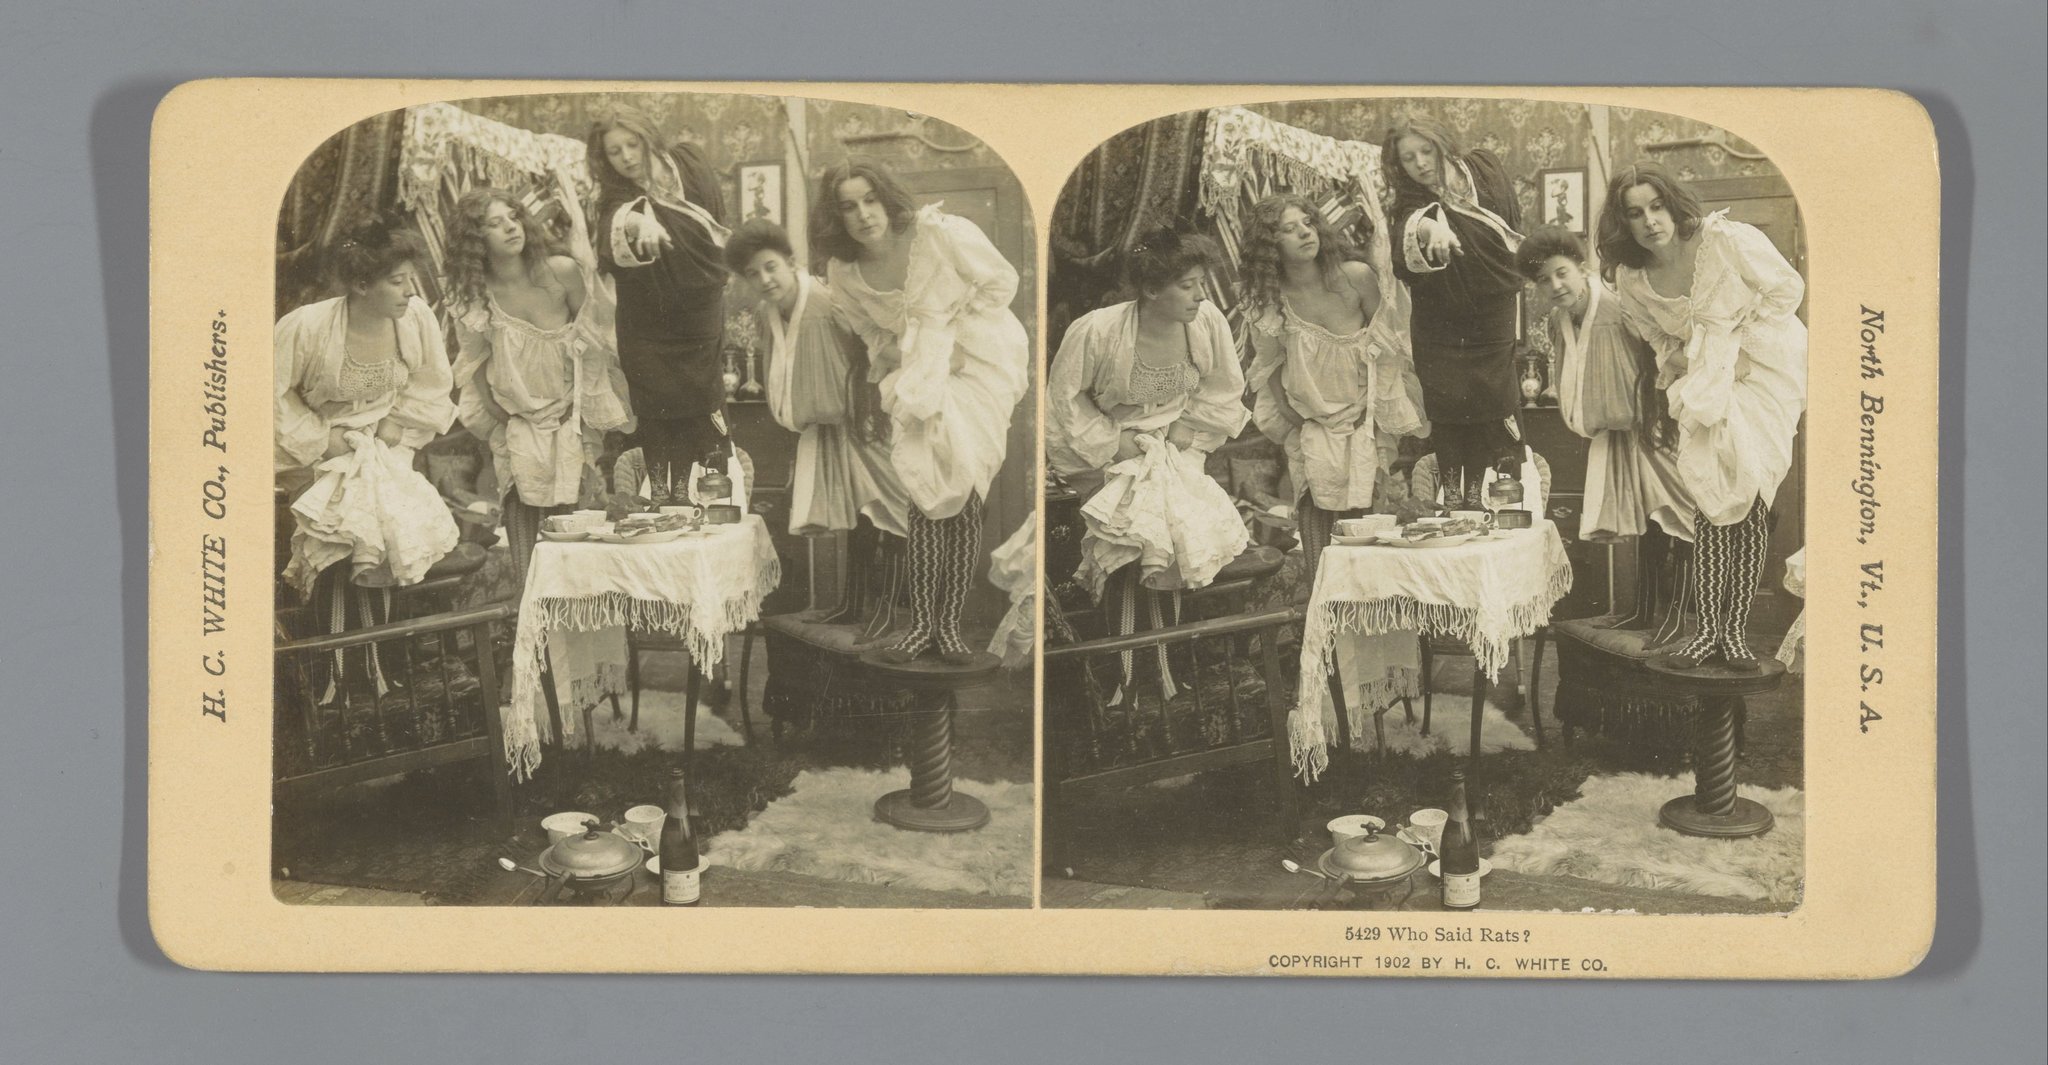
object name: stereograph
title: Groep jonge vrouwen in nachtkleding staat met opgetrokken rokken op tafels en stoelen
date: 1902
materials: cardboard, photographic support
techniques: gelatin silver print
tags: kitchen-utensils: pan, bottle of wine, nightwear: night-gown, living-room, parlour, sitting-room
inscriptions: number: ‘5429’, : ‘North Bennington, Vt., U.S.A.’